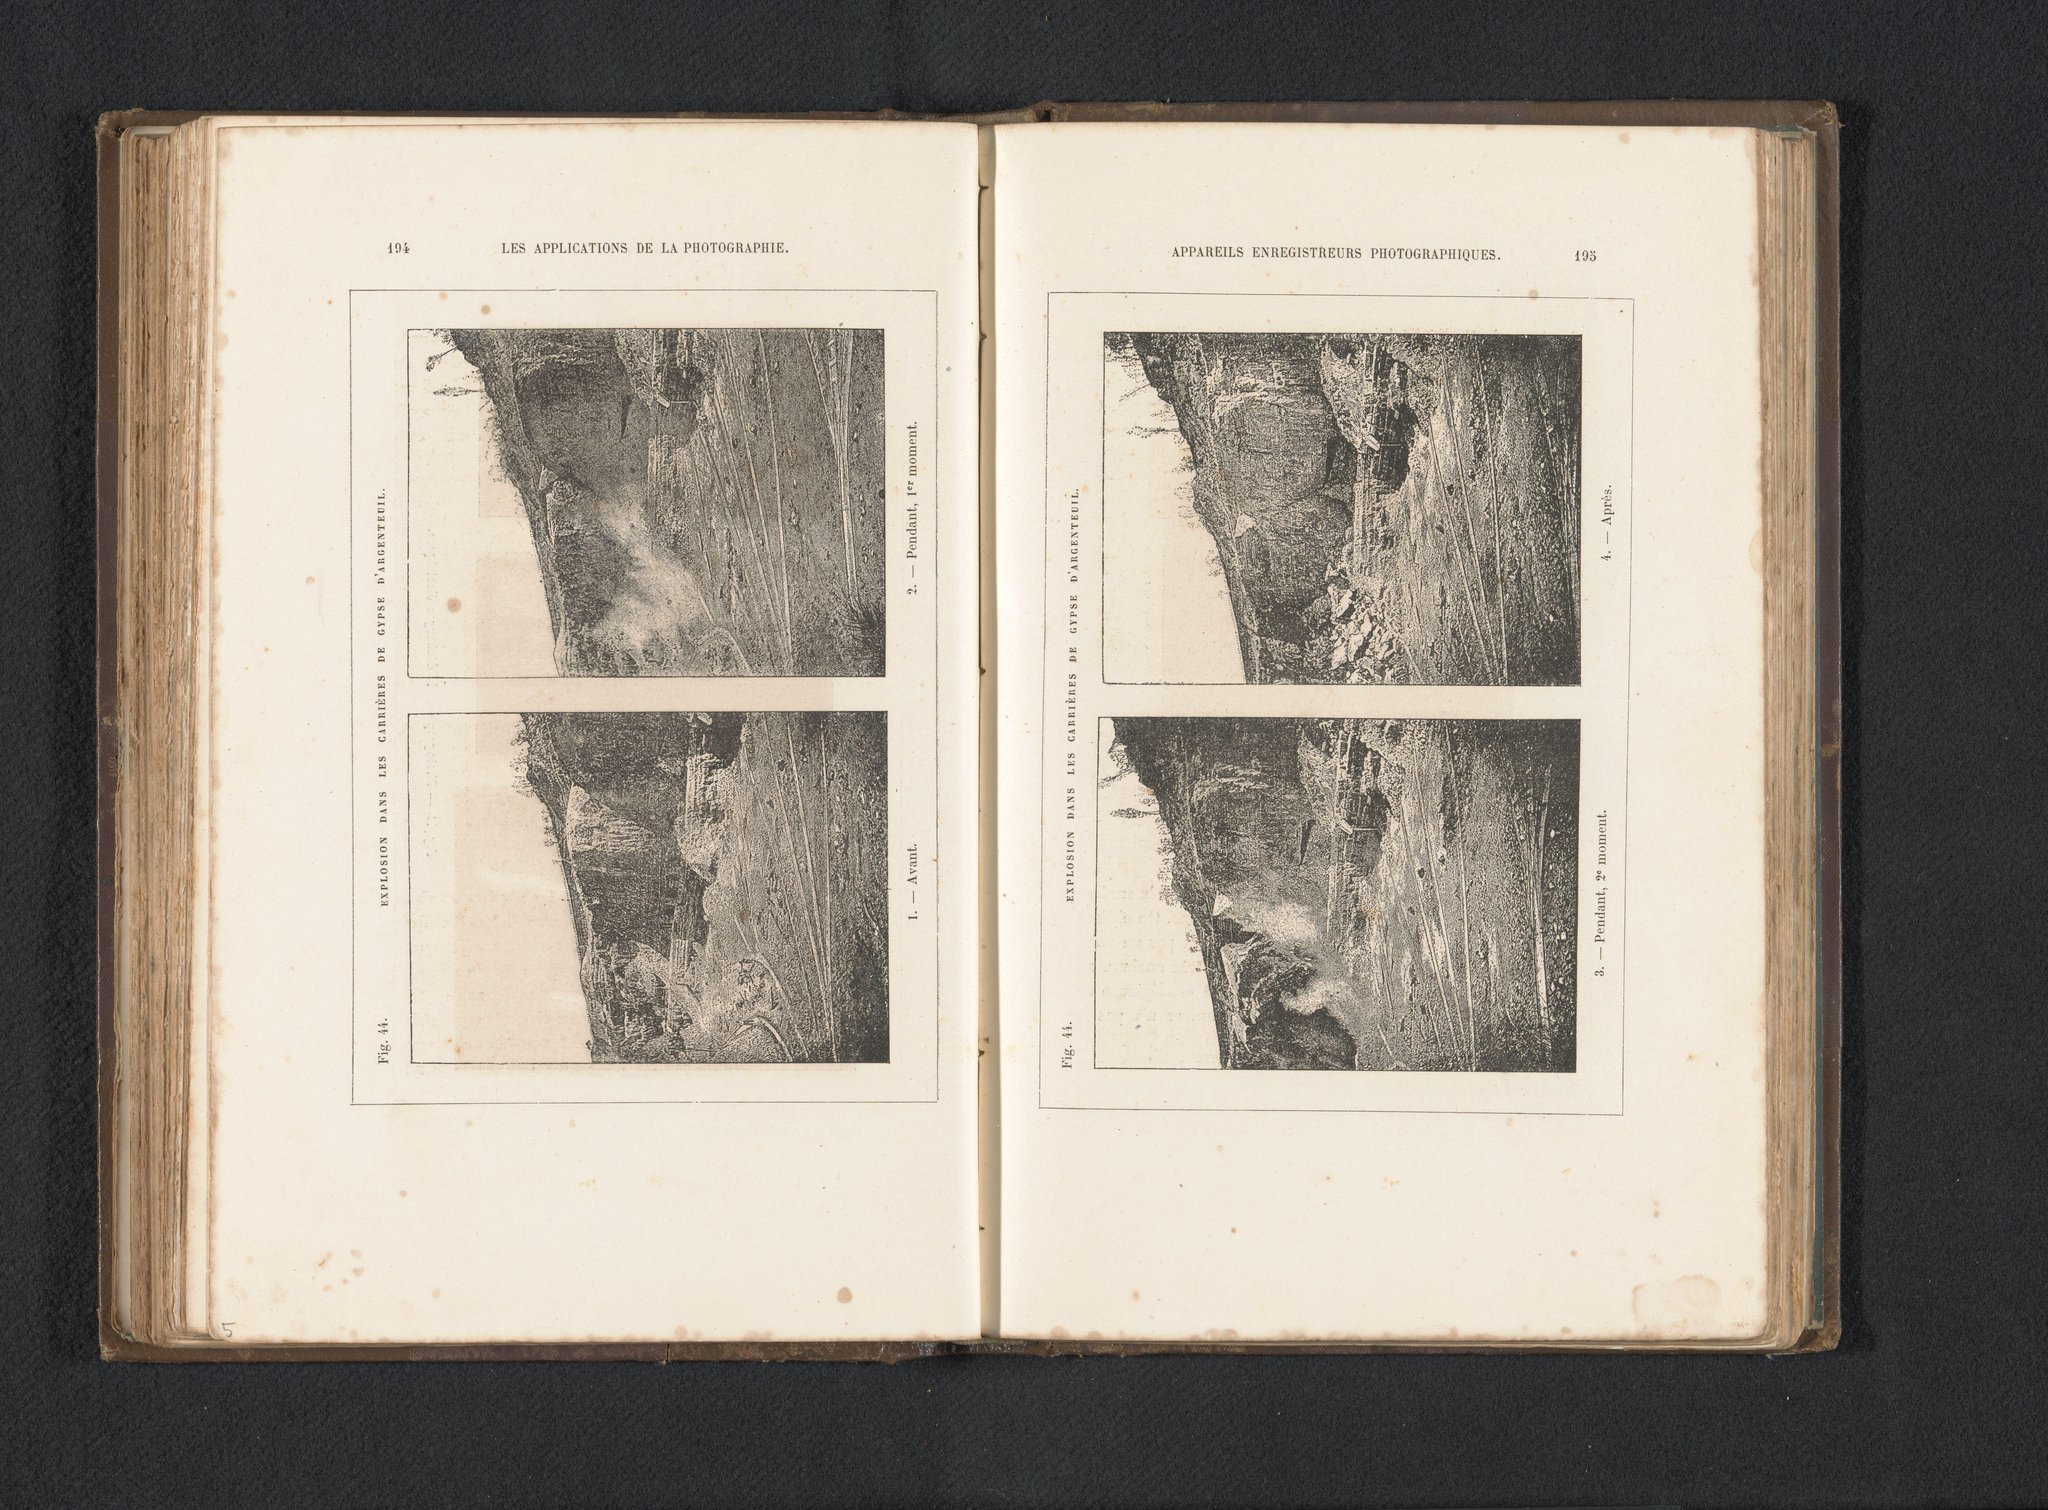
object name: page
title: Twee opnamen van een steengroeve tijdens de voorbereidingen van een explosie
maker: Anonymous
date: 1883-1888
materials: paper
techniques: collo-autotype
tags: quarry (+ stone)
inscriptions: inscription: ‘Fig. 44. Expliosion dans les carrières de gypse d'argenteuil/ 1. - Avant./ 2. - Pendant, 1er moment.’